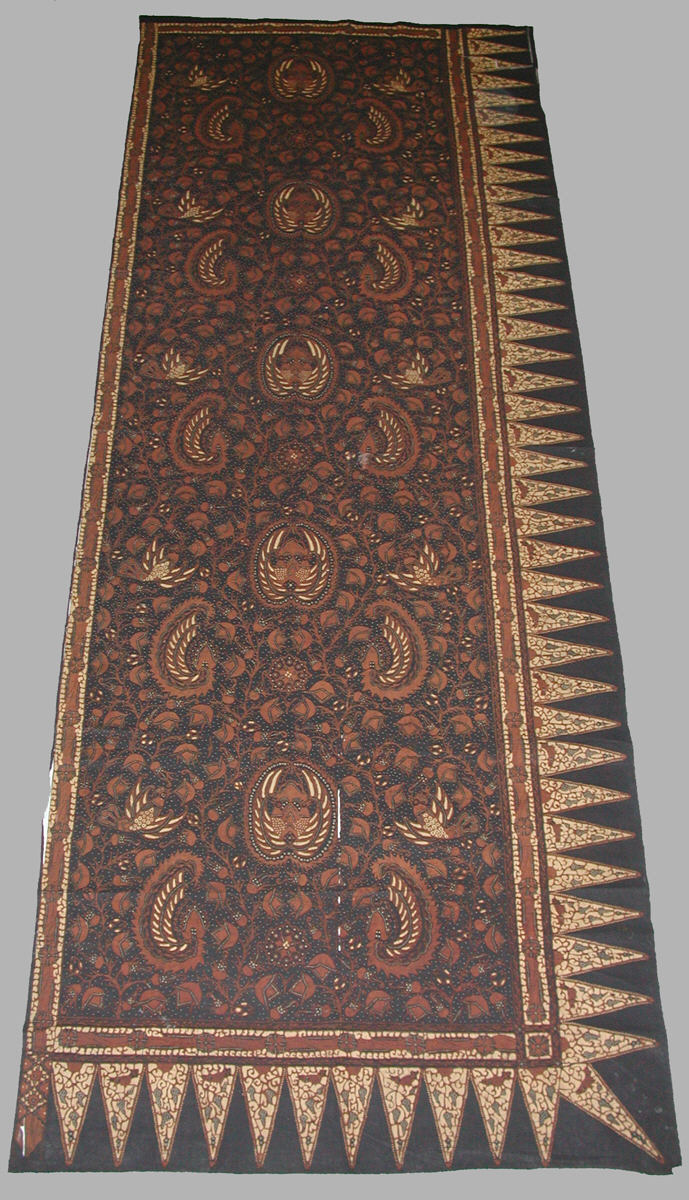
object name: panel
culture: javanese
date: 1867-1933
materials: cotton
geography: indonesia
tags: flowers